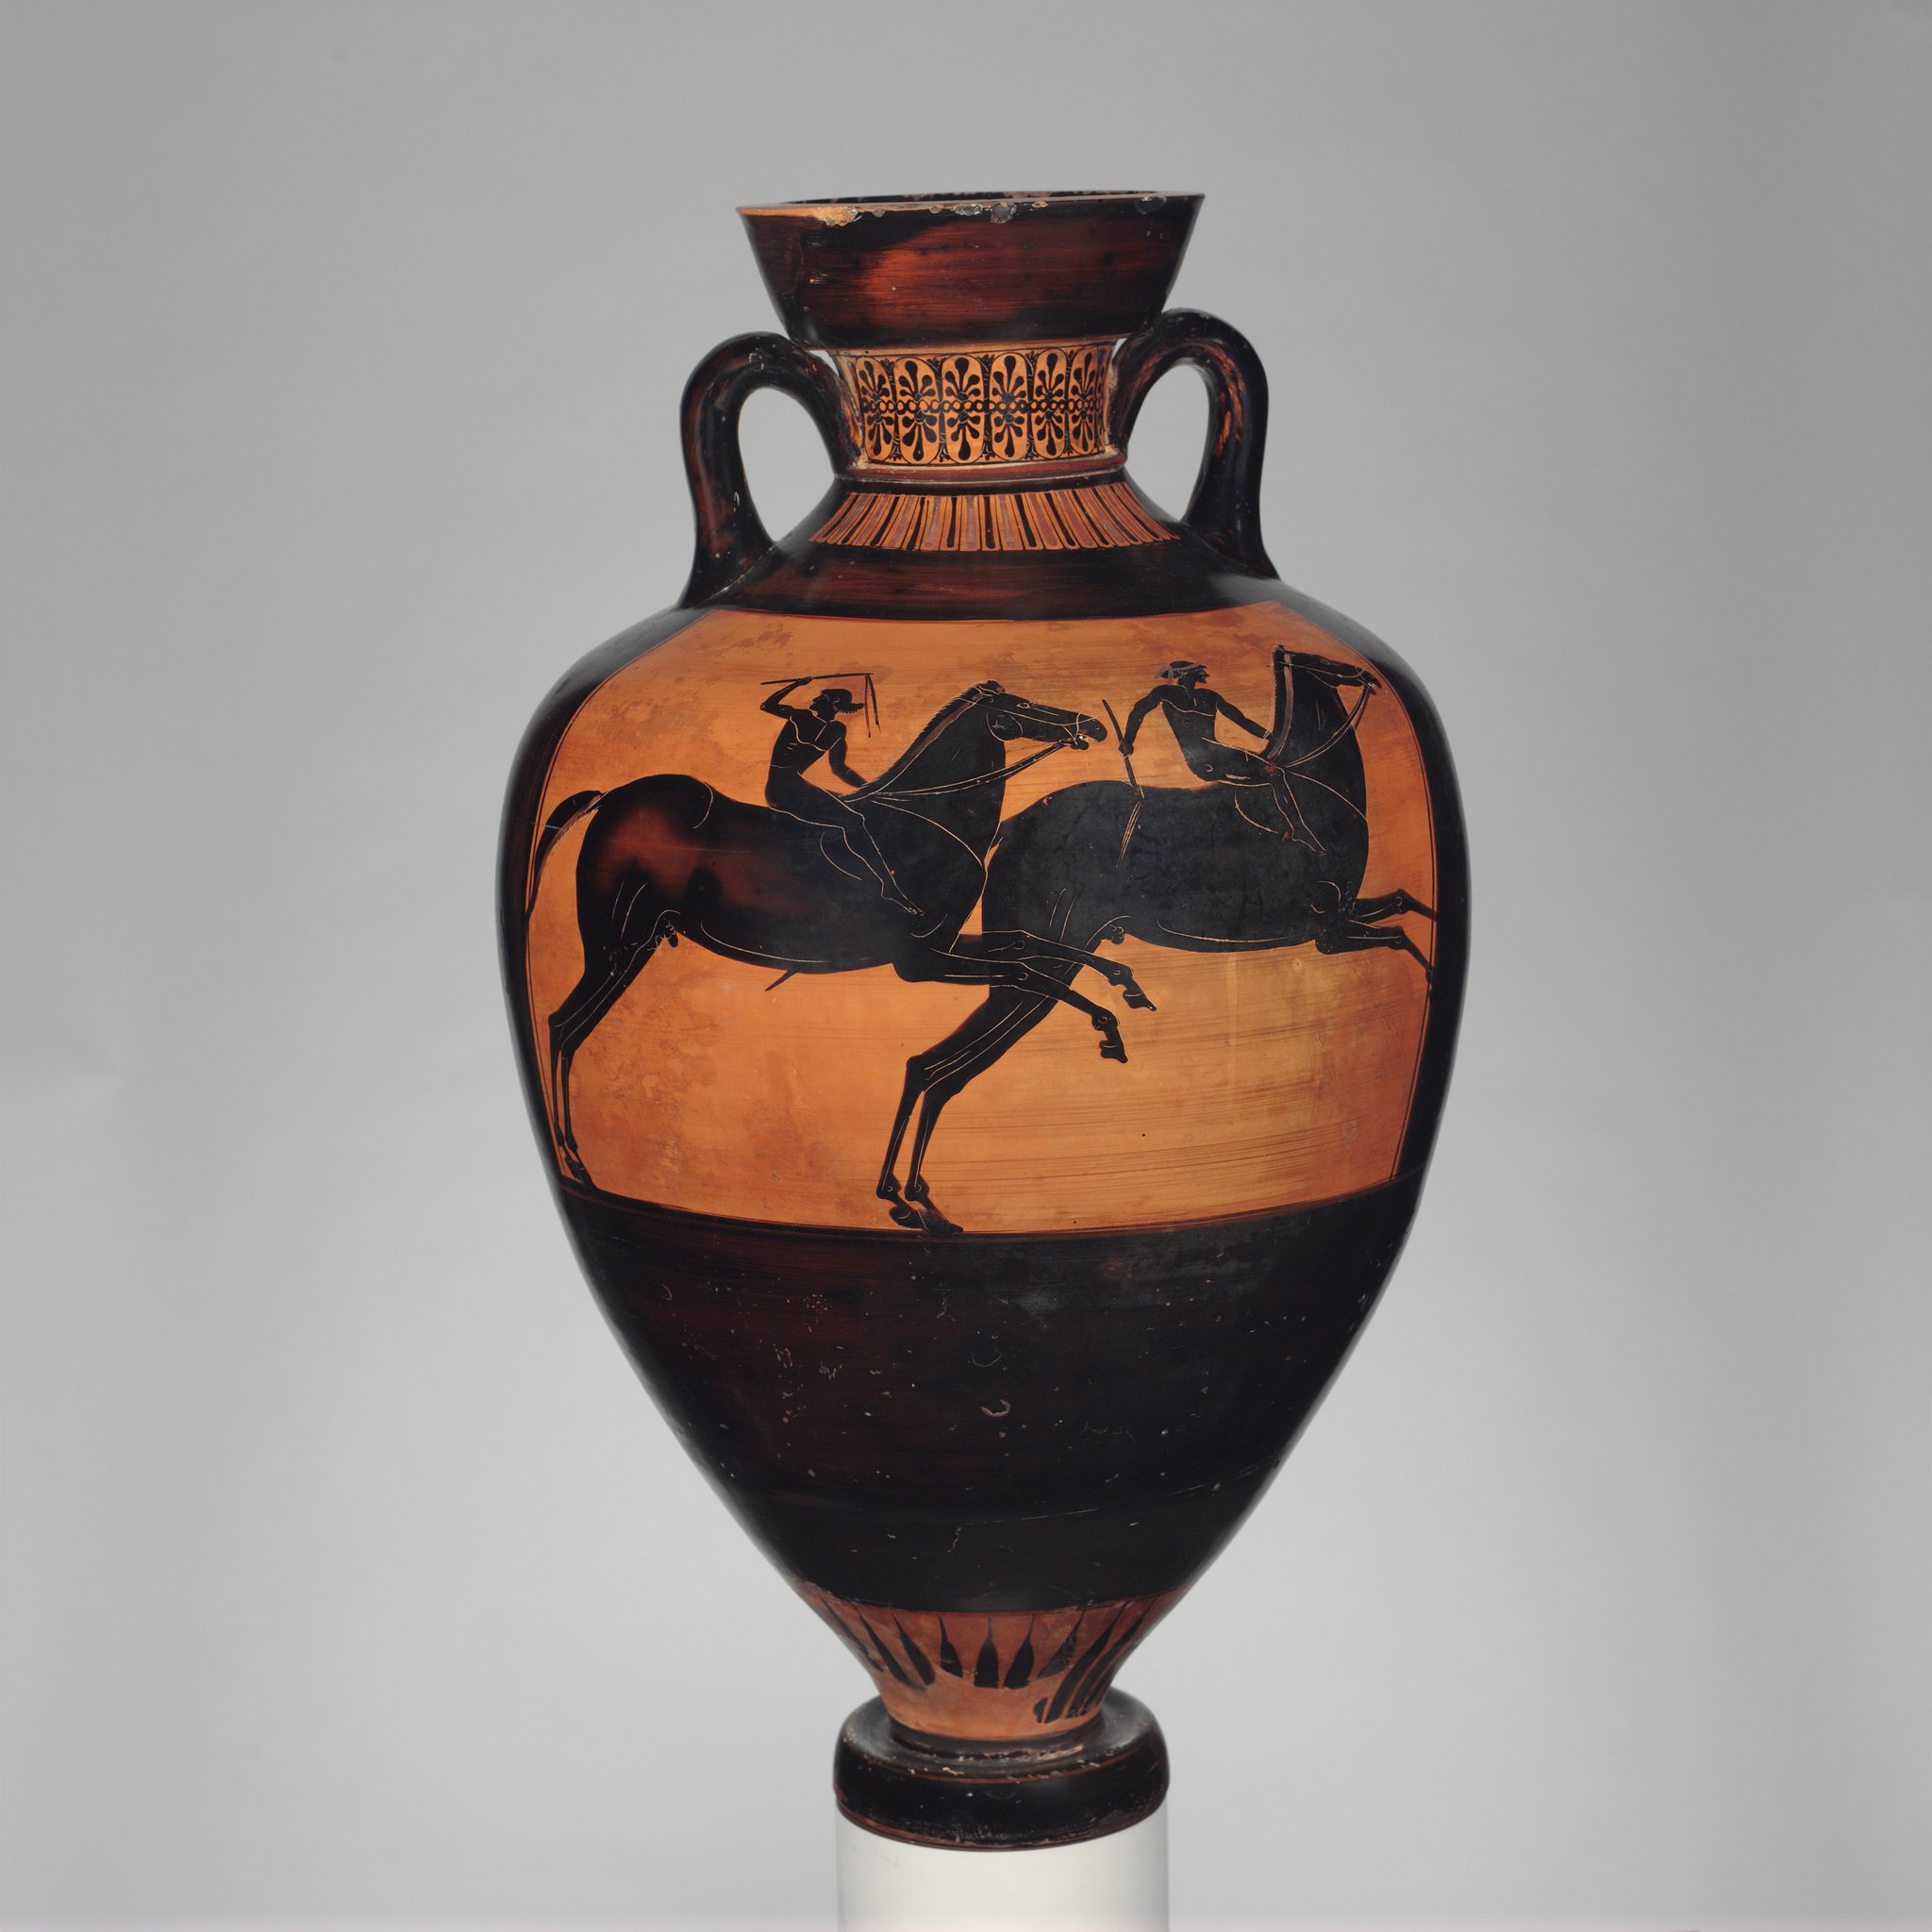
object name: panathenaic prize amphora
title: Terracotta Panathenaic prize amphora (jar)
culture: greek, attic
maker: eucharides painter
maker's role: artist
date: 490 BCE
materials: terracotta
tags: athena,horses,jockeys